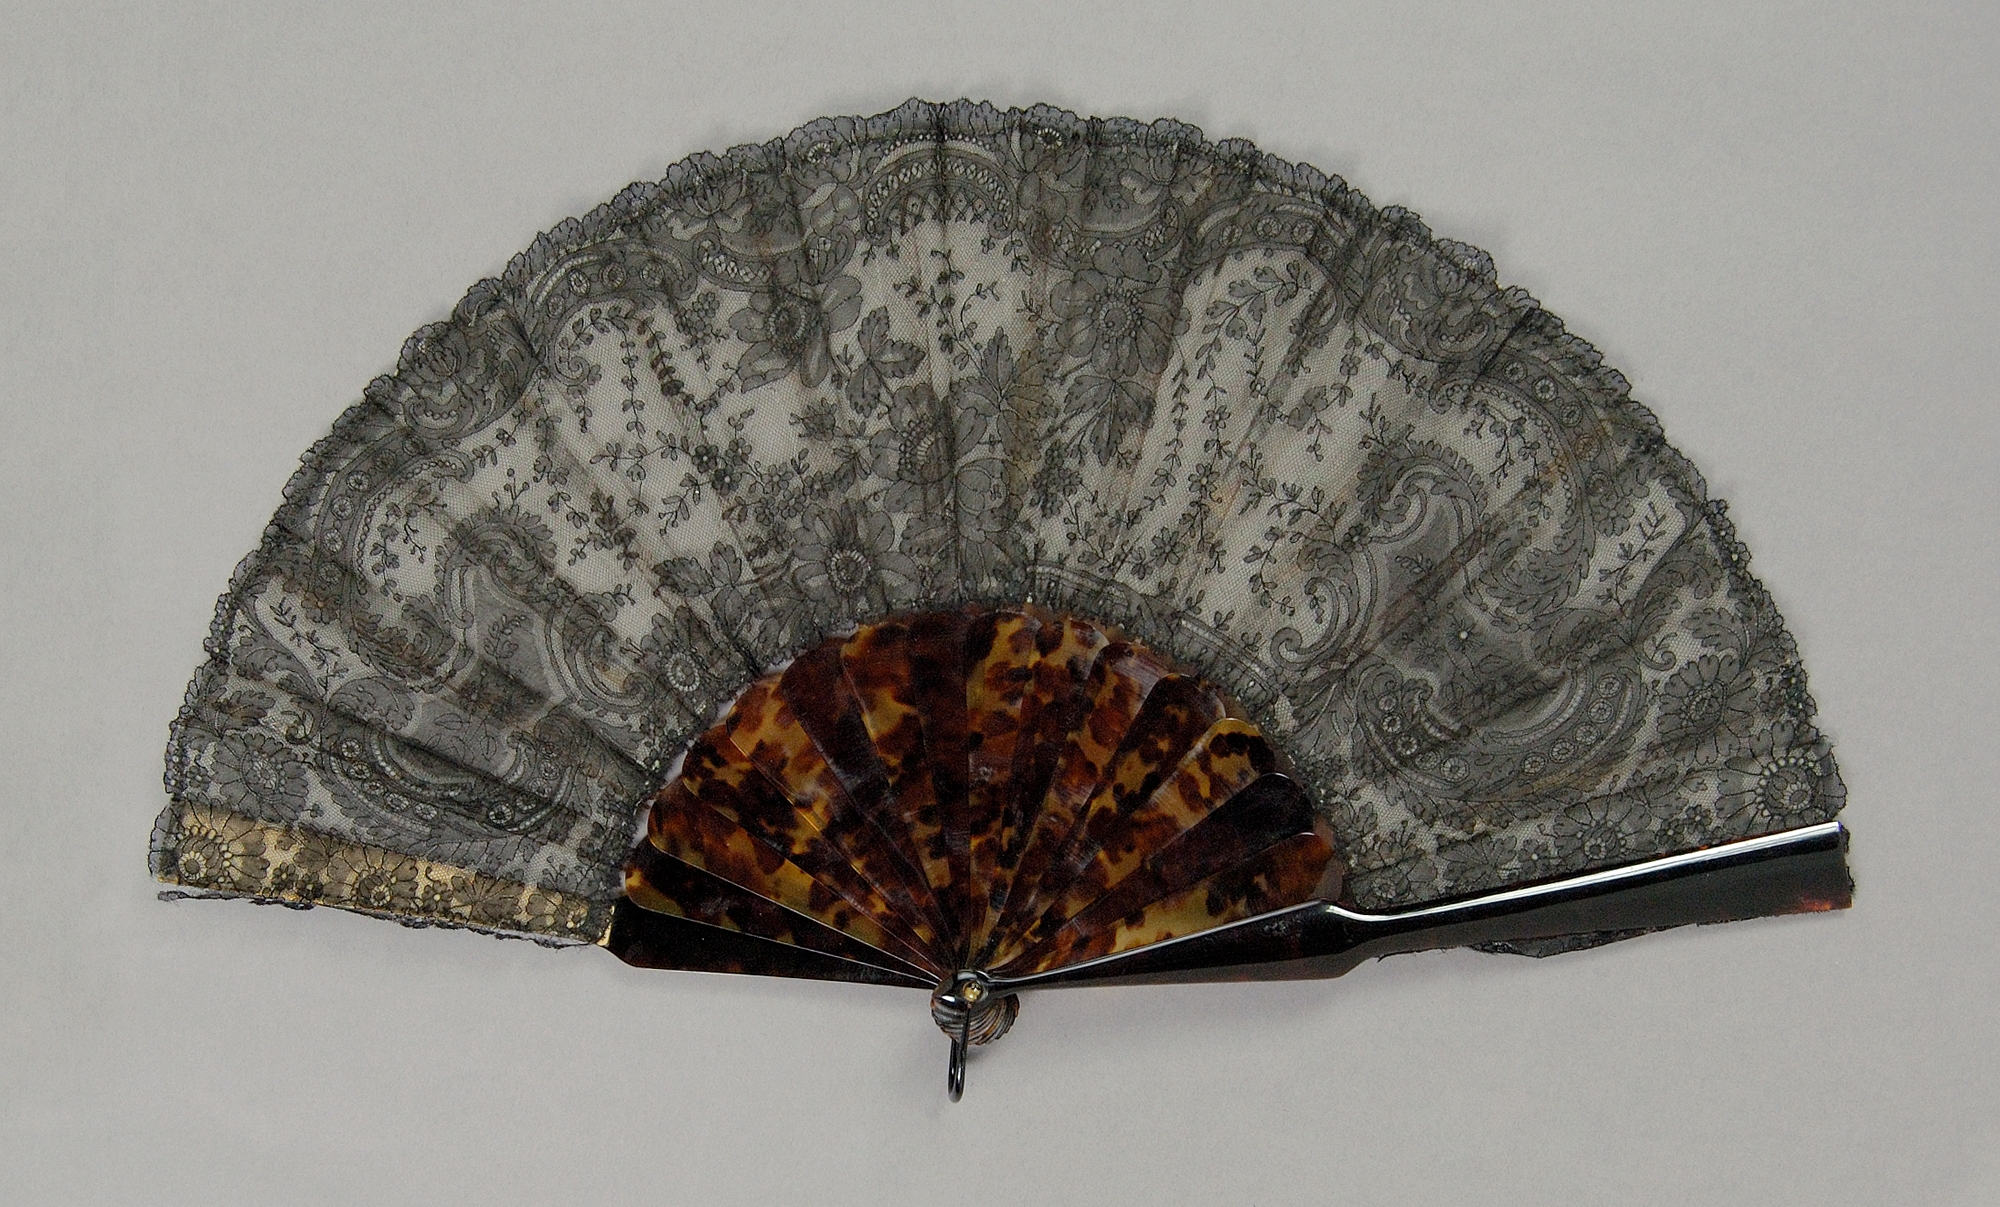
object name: fan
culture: french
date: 1870-1889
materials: silk, shell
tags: flowers